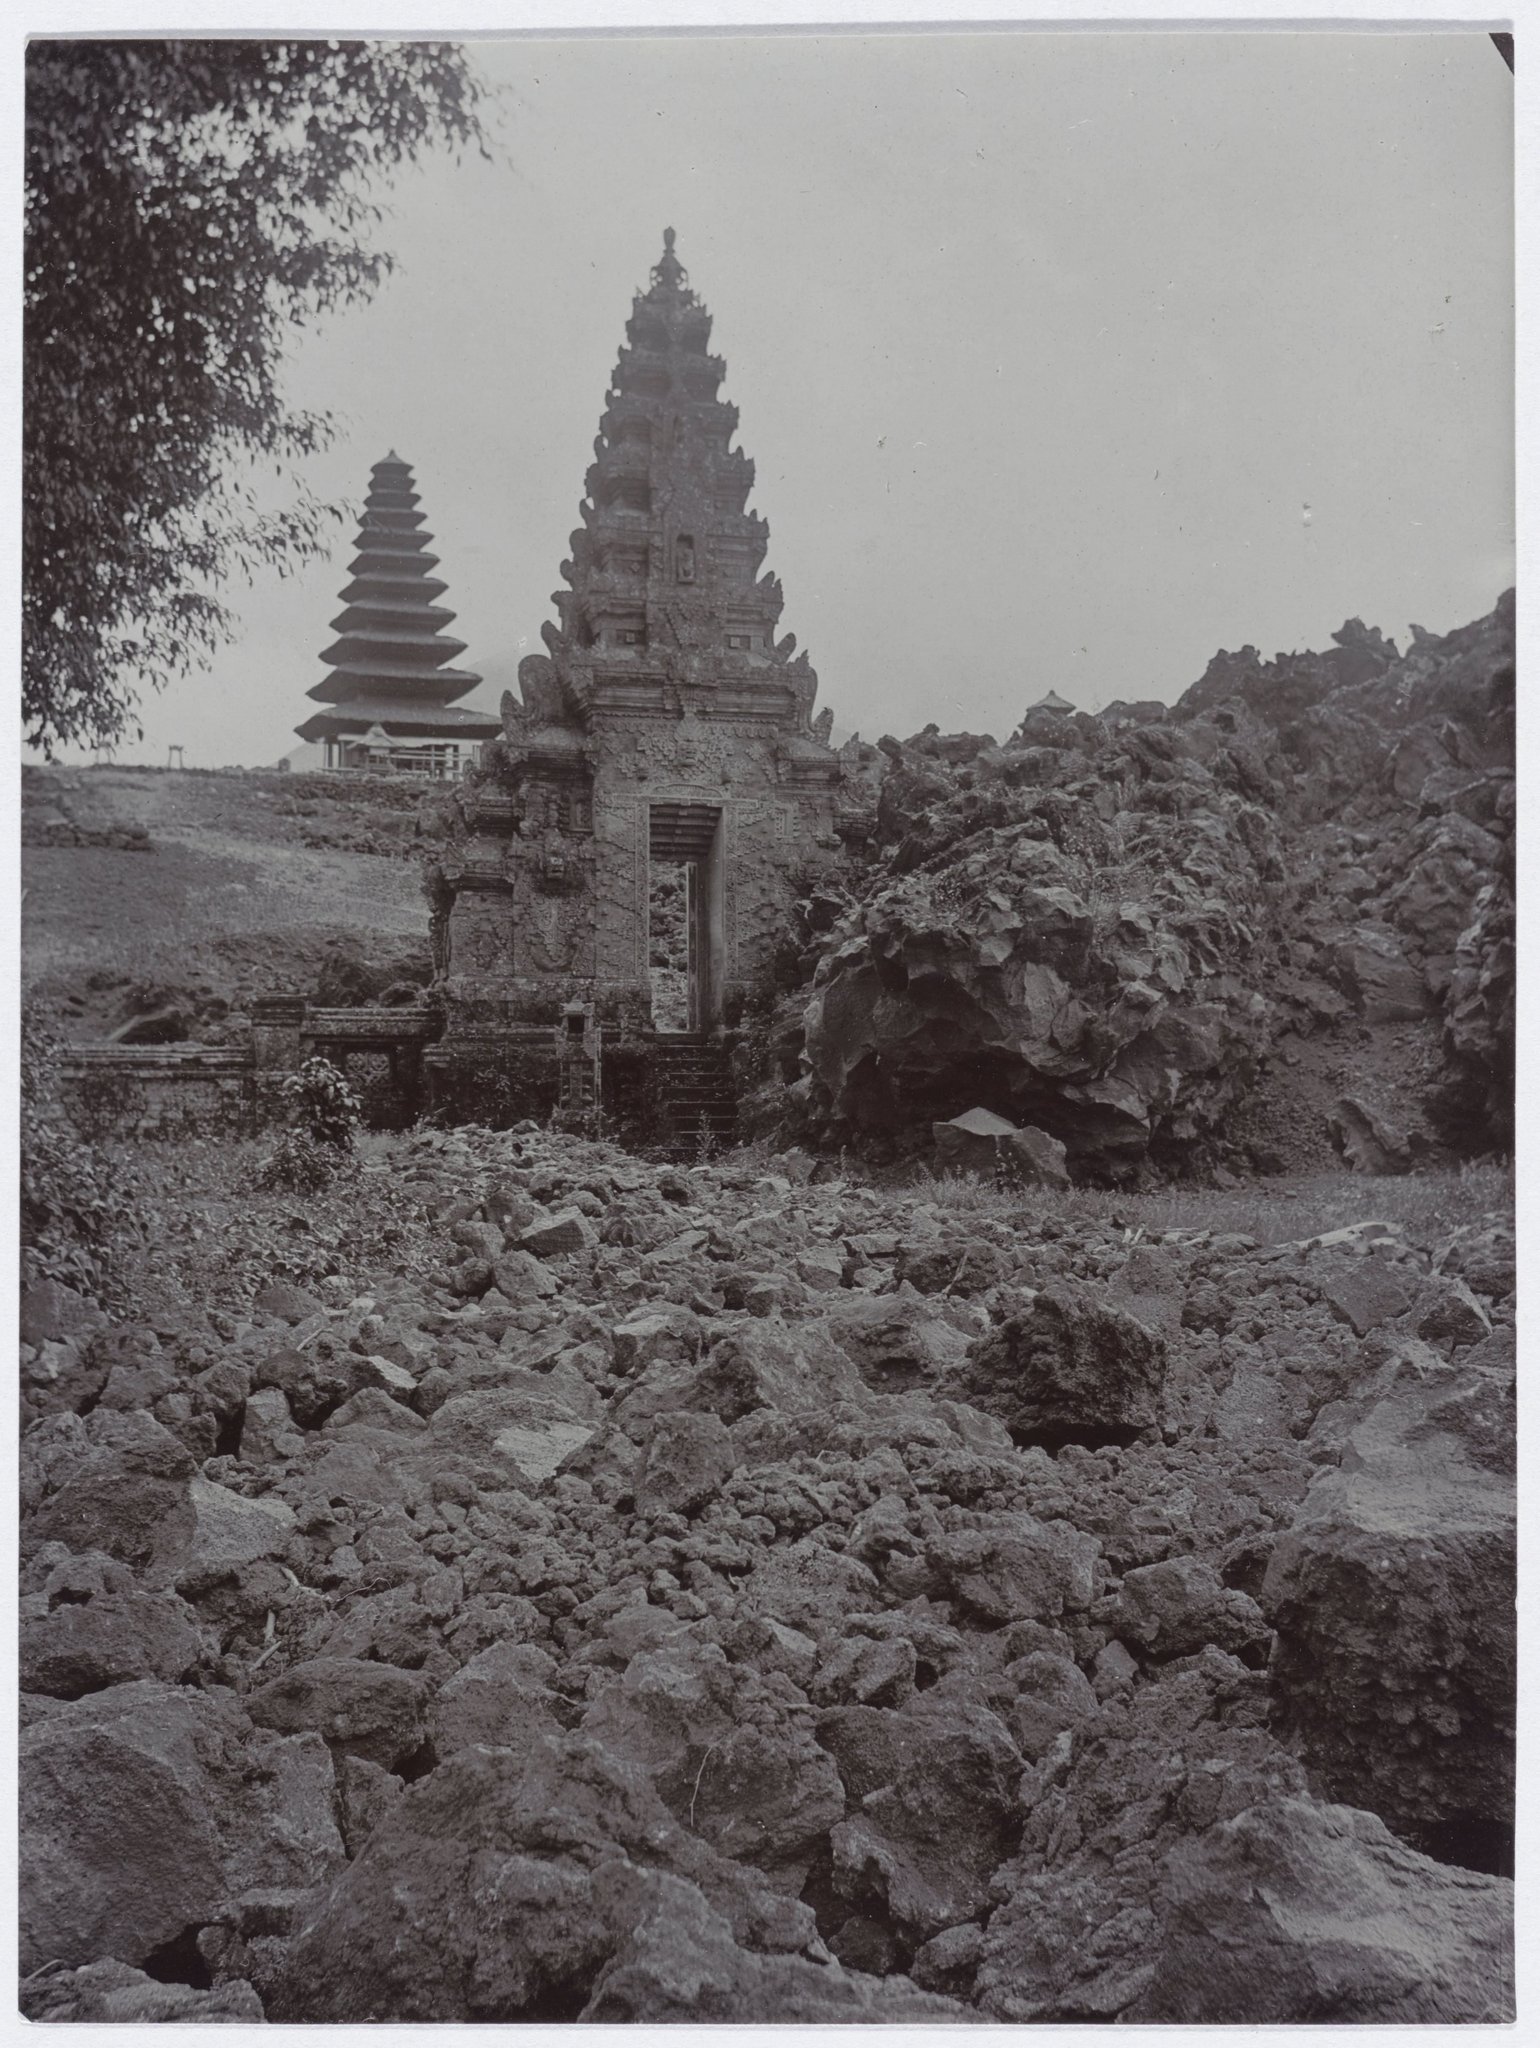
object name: photograph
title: 14. midden Bali.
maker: johanna hermina marmelstein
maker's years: 1897-1990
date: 1900-1915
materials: paper, photographic support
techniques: albumen print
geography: jakarta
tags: bali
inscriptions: annotation: ‘14. midden Bali. vooraanzicht. Poera te Batoer , met meroek achtergrond. Bij de laatste uitbarsting van de Batoer ong. 30 jaar geleden, kwam de lavastroom niet verder dan tot deze binnepoort. Sinds dien is deze poera in hoog aanzien gekomen en worden elk jaar groote bedevaarten er heen ondernomen.’